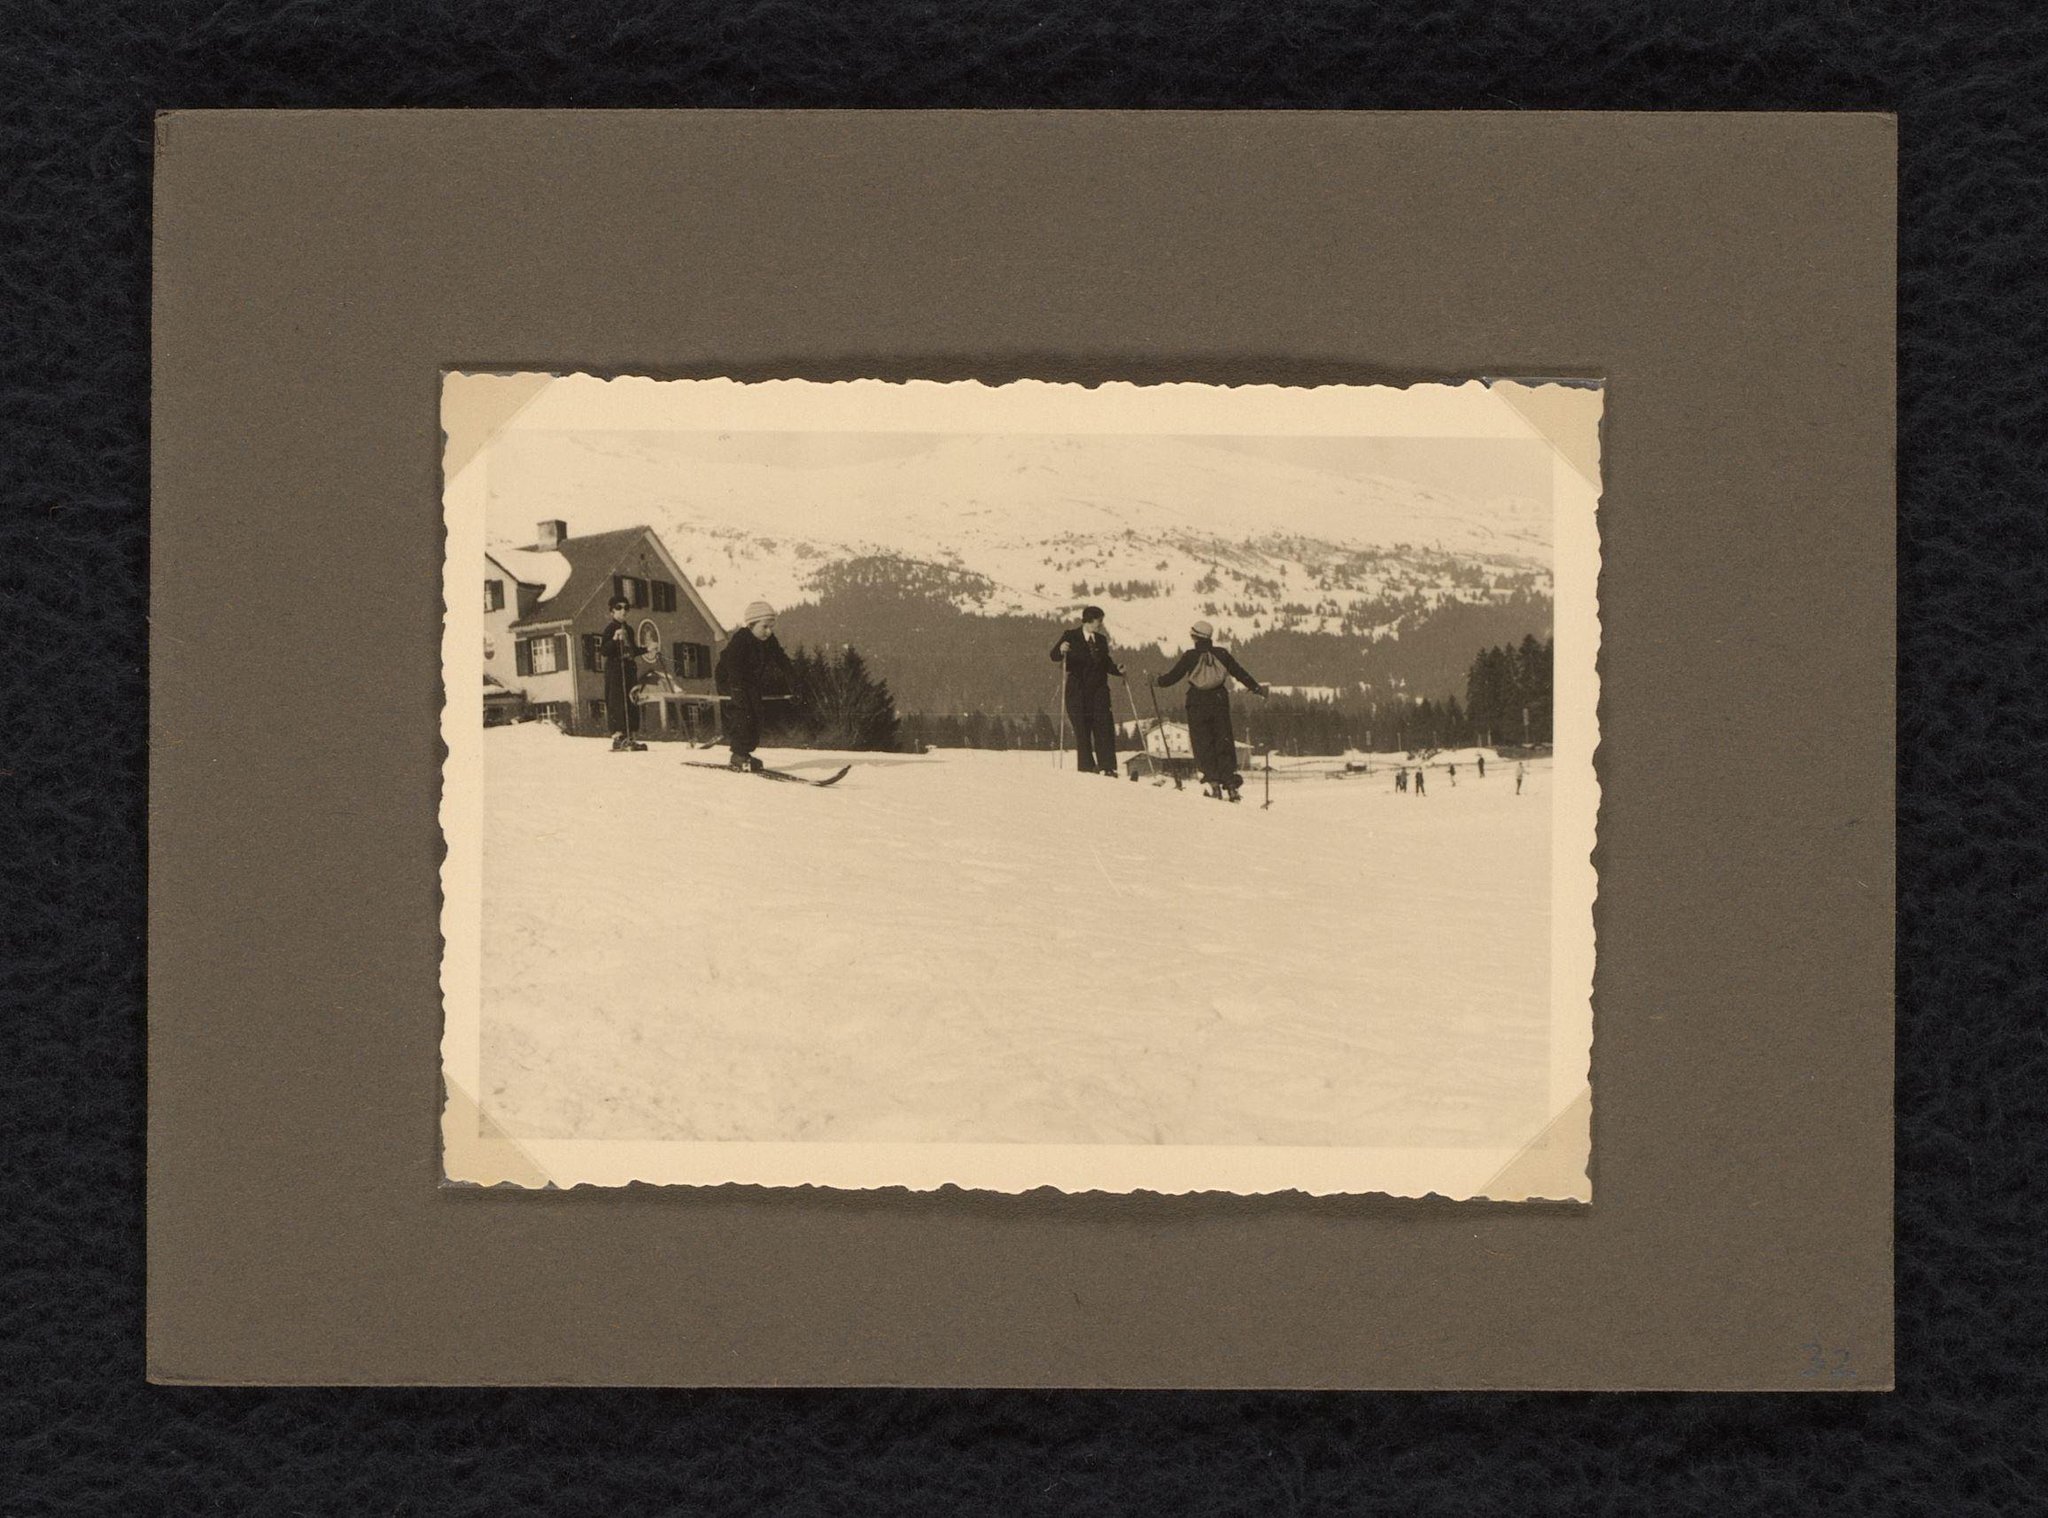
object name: album leaf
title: Isabel op ski's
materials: cardboard, photographic support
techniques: gelatin silver print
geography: lenzerheide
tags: leiden, isabel wachenheimer-elon, skis (winter sports), the family travelling, on holiday, snow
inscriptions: date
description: Albumblad met een foto van Isabel Wachenheimer staande op ski's. Onderdeel van het fotoalbum met vakantiefoto's Lenzerheide, 1934.